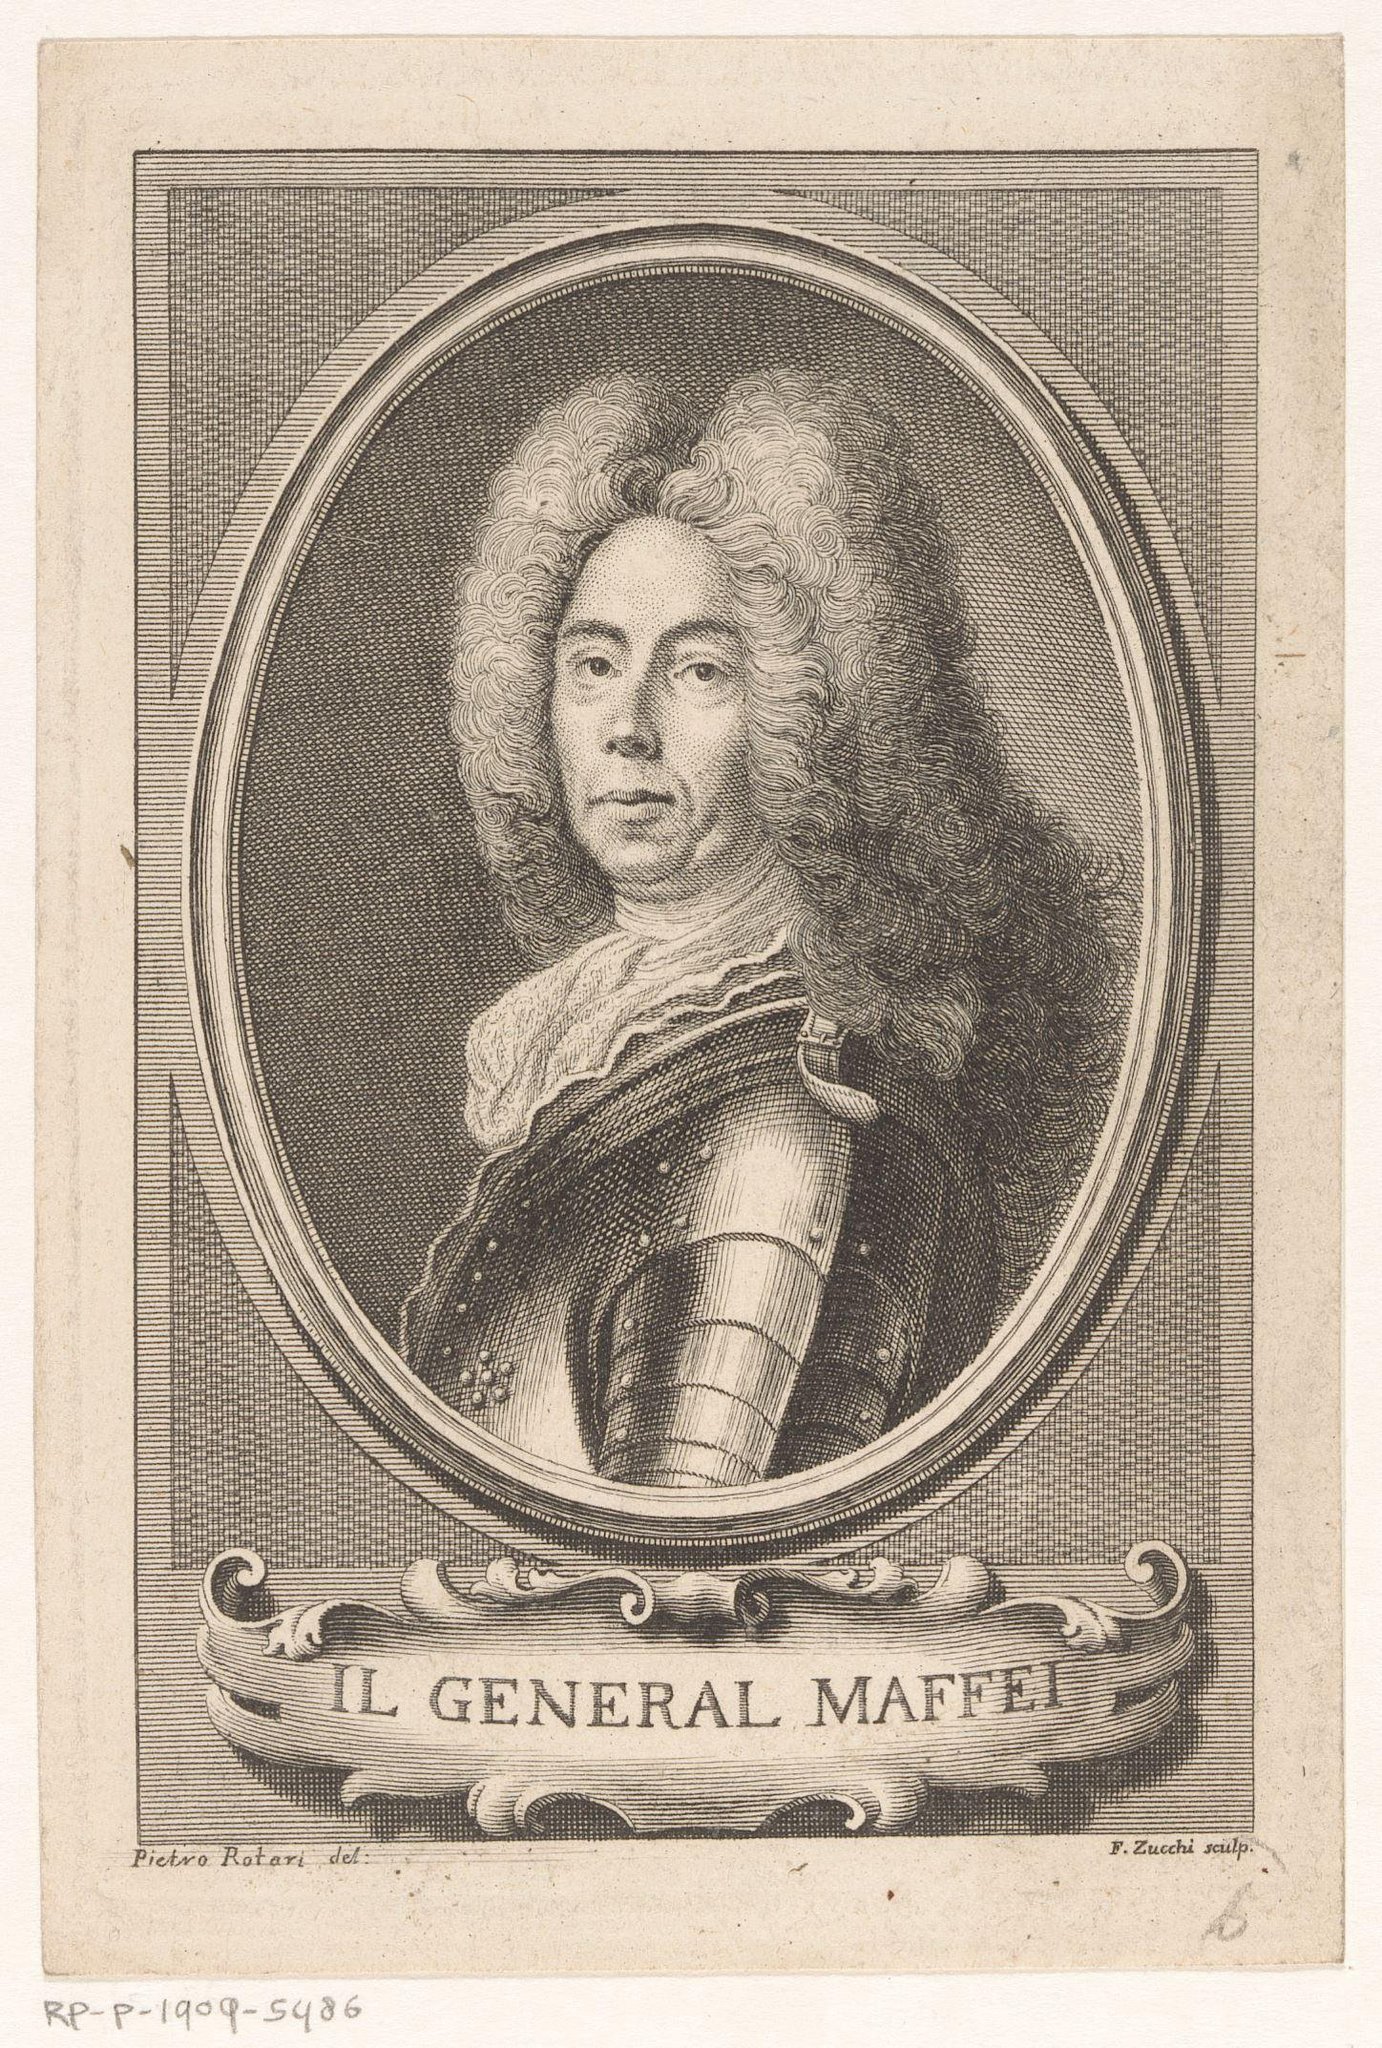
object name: print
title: Portret van markies Alessandro Maffei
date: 1702-1764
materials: paper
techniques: engraving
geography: italy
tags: armour, historical persons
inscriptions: collector's mark: Lugt 2228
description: Buste naar links van de luitenant-generaal en markies Alessandro Maffei in wapenrusting. Onder de ovale omlijsting de naam van de geportretteerde in een cartouche.